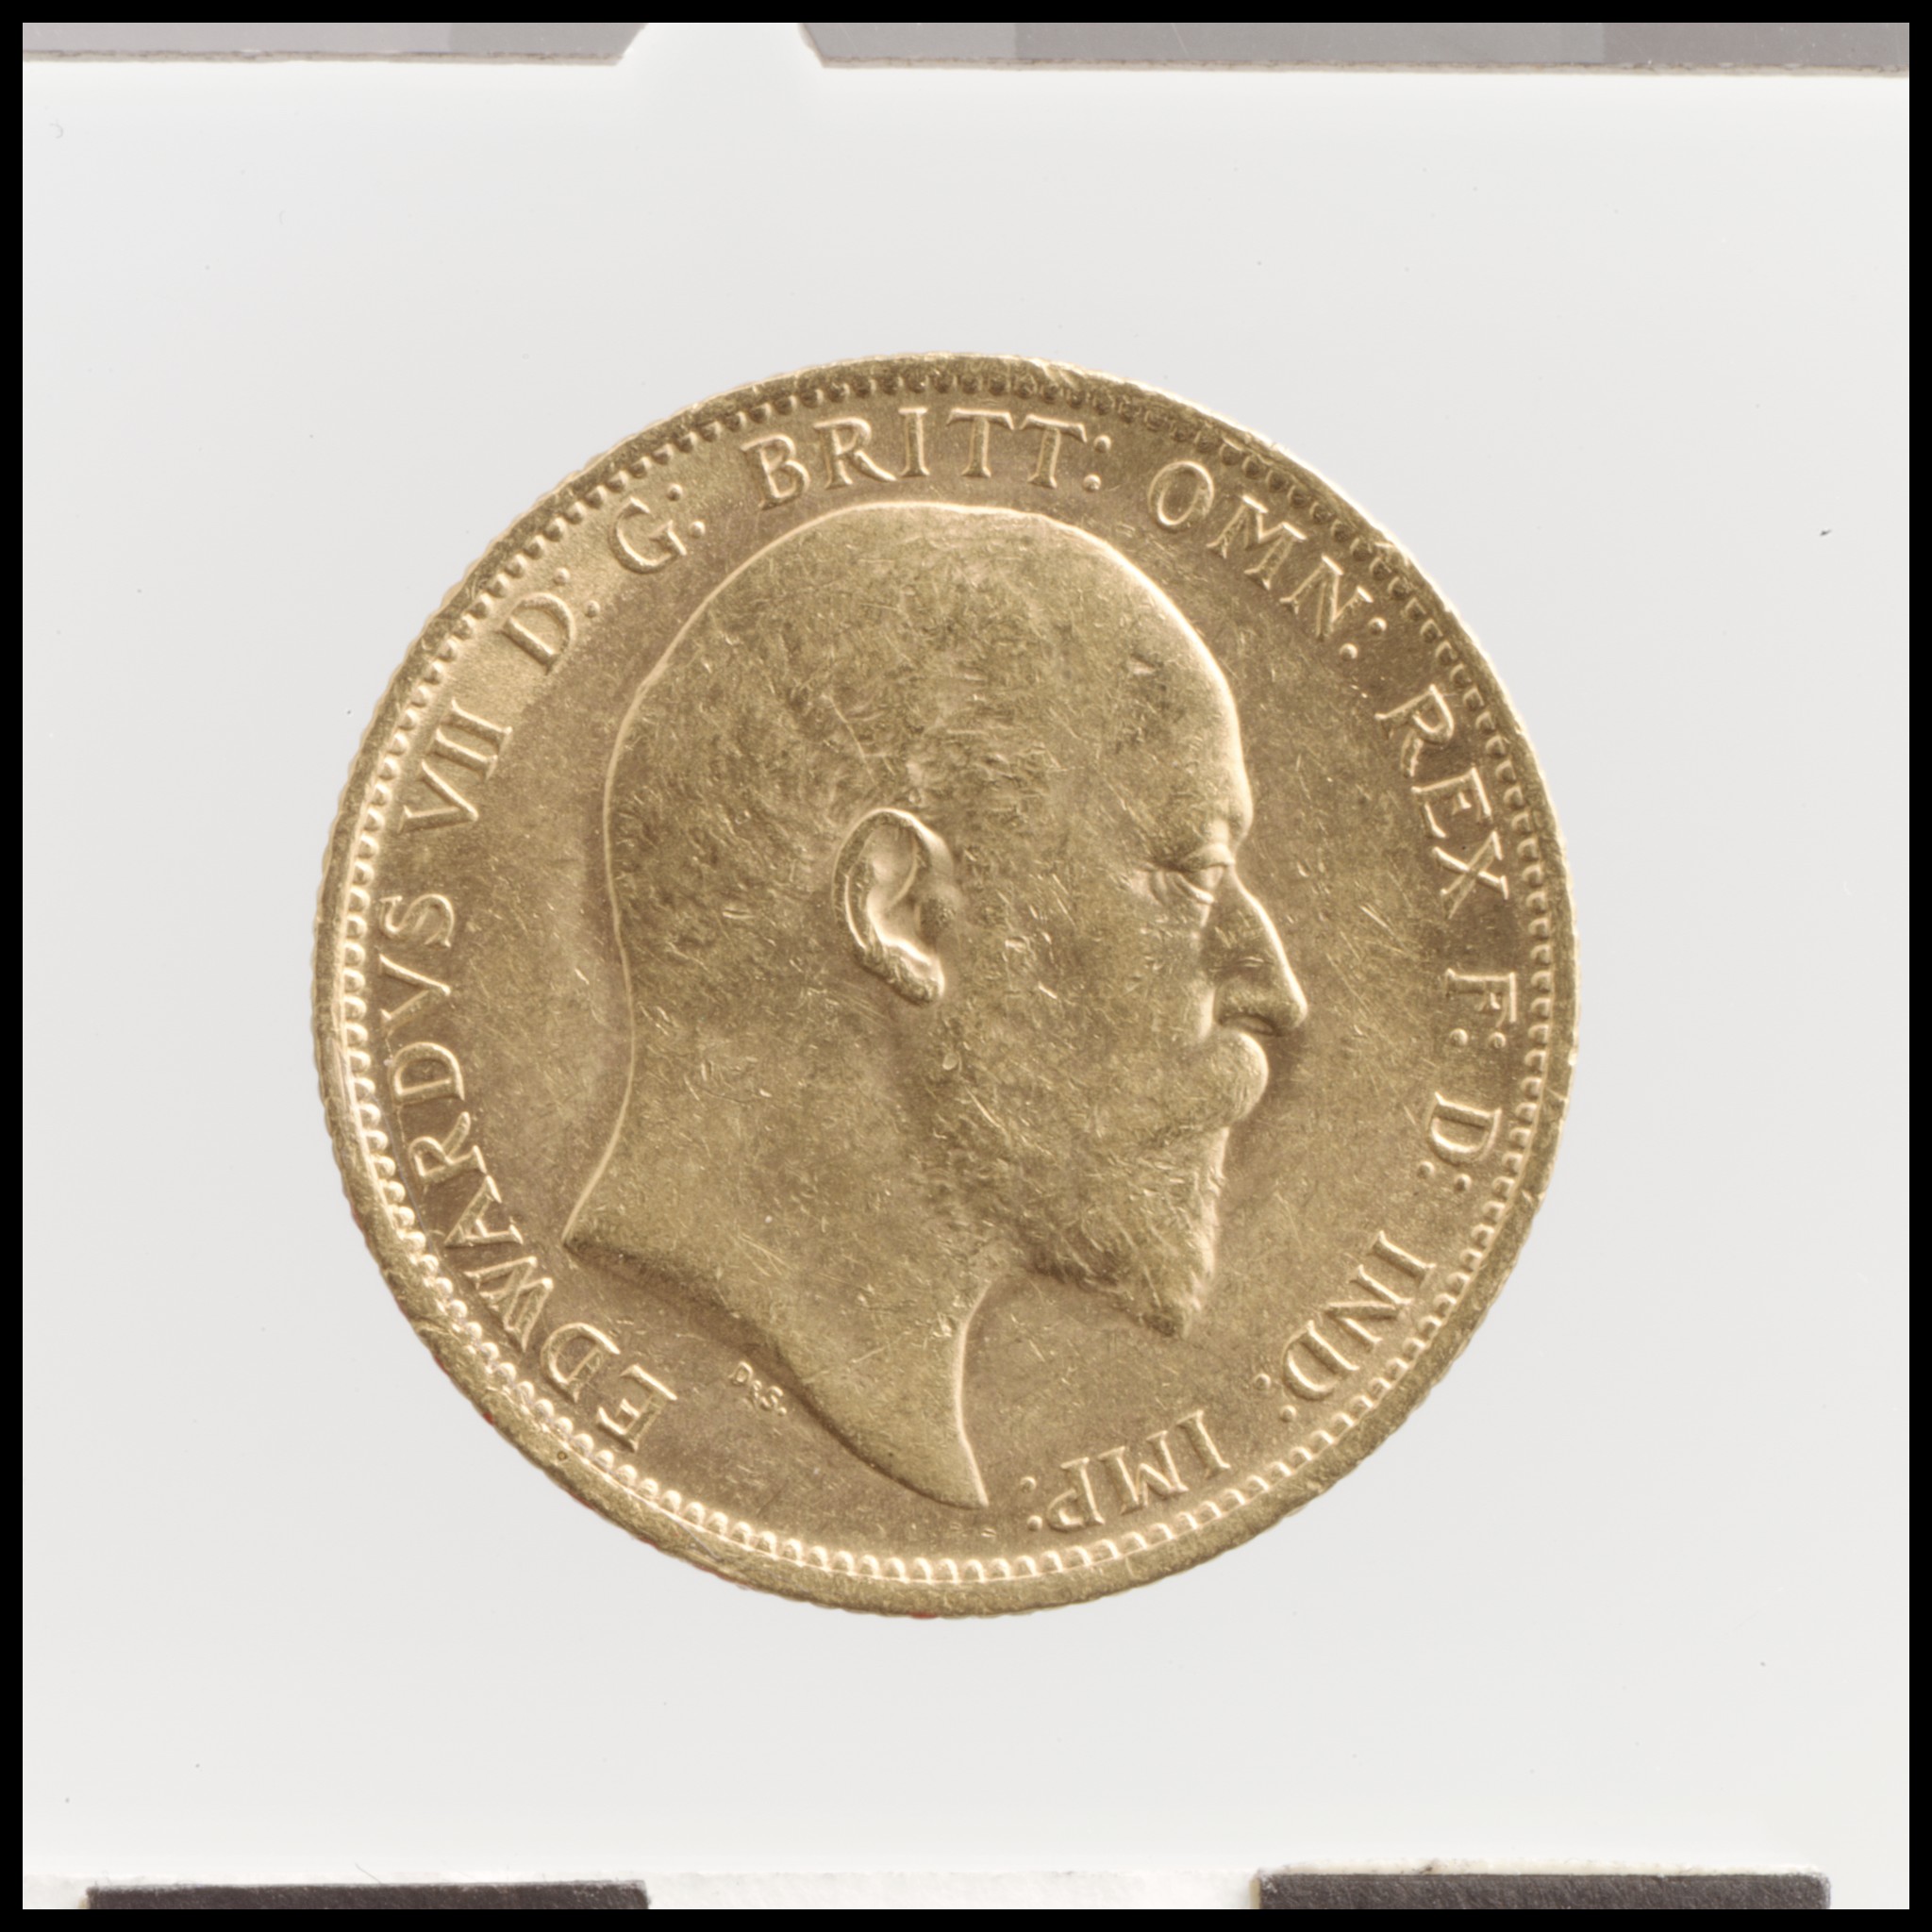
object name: sovereign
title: Edward VII sovereign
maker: g.w. desaulles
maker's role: maker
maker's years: 1862-1903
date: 1902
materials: gold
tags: men,profiles,dragons,horses